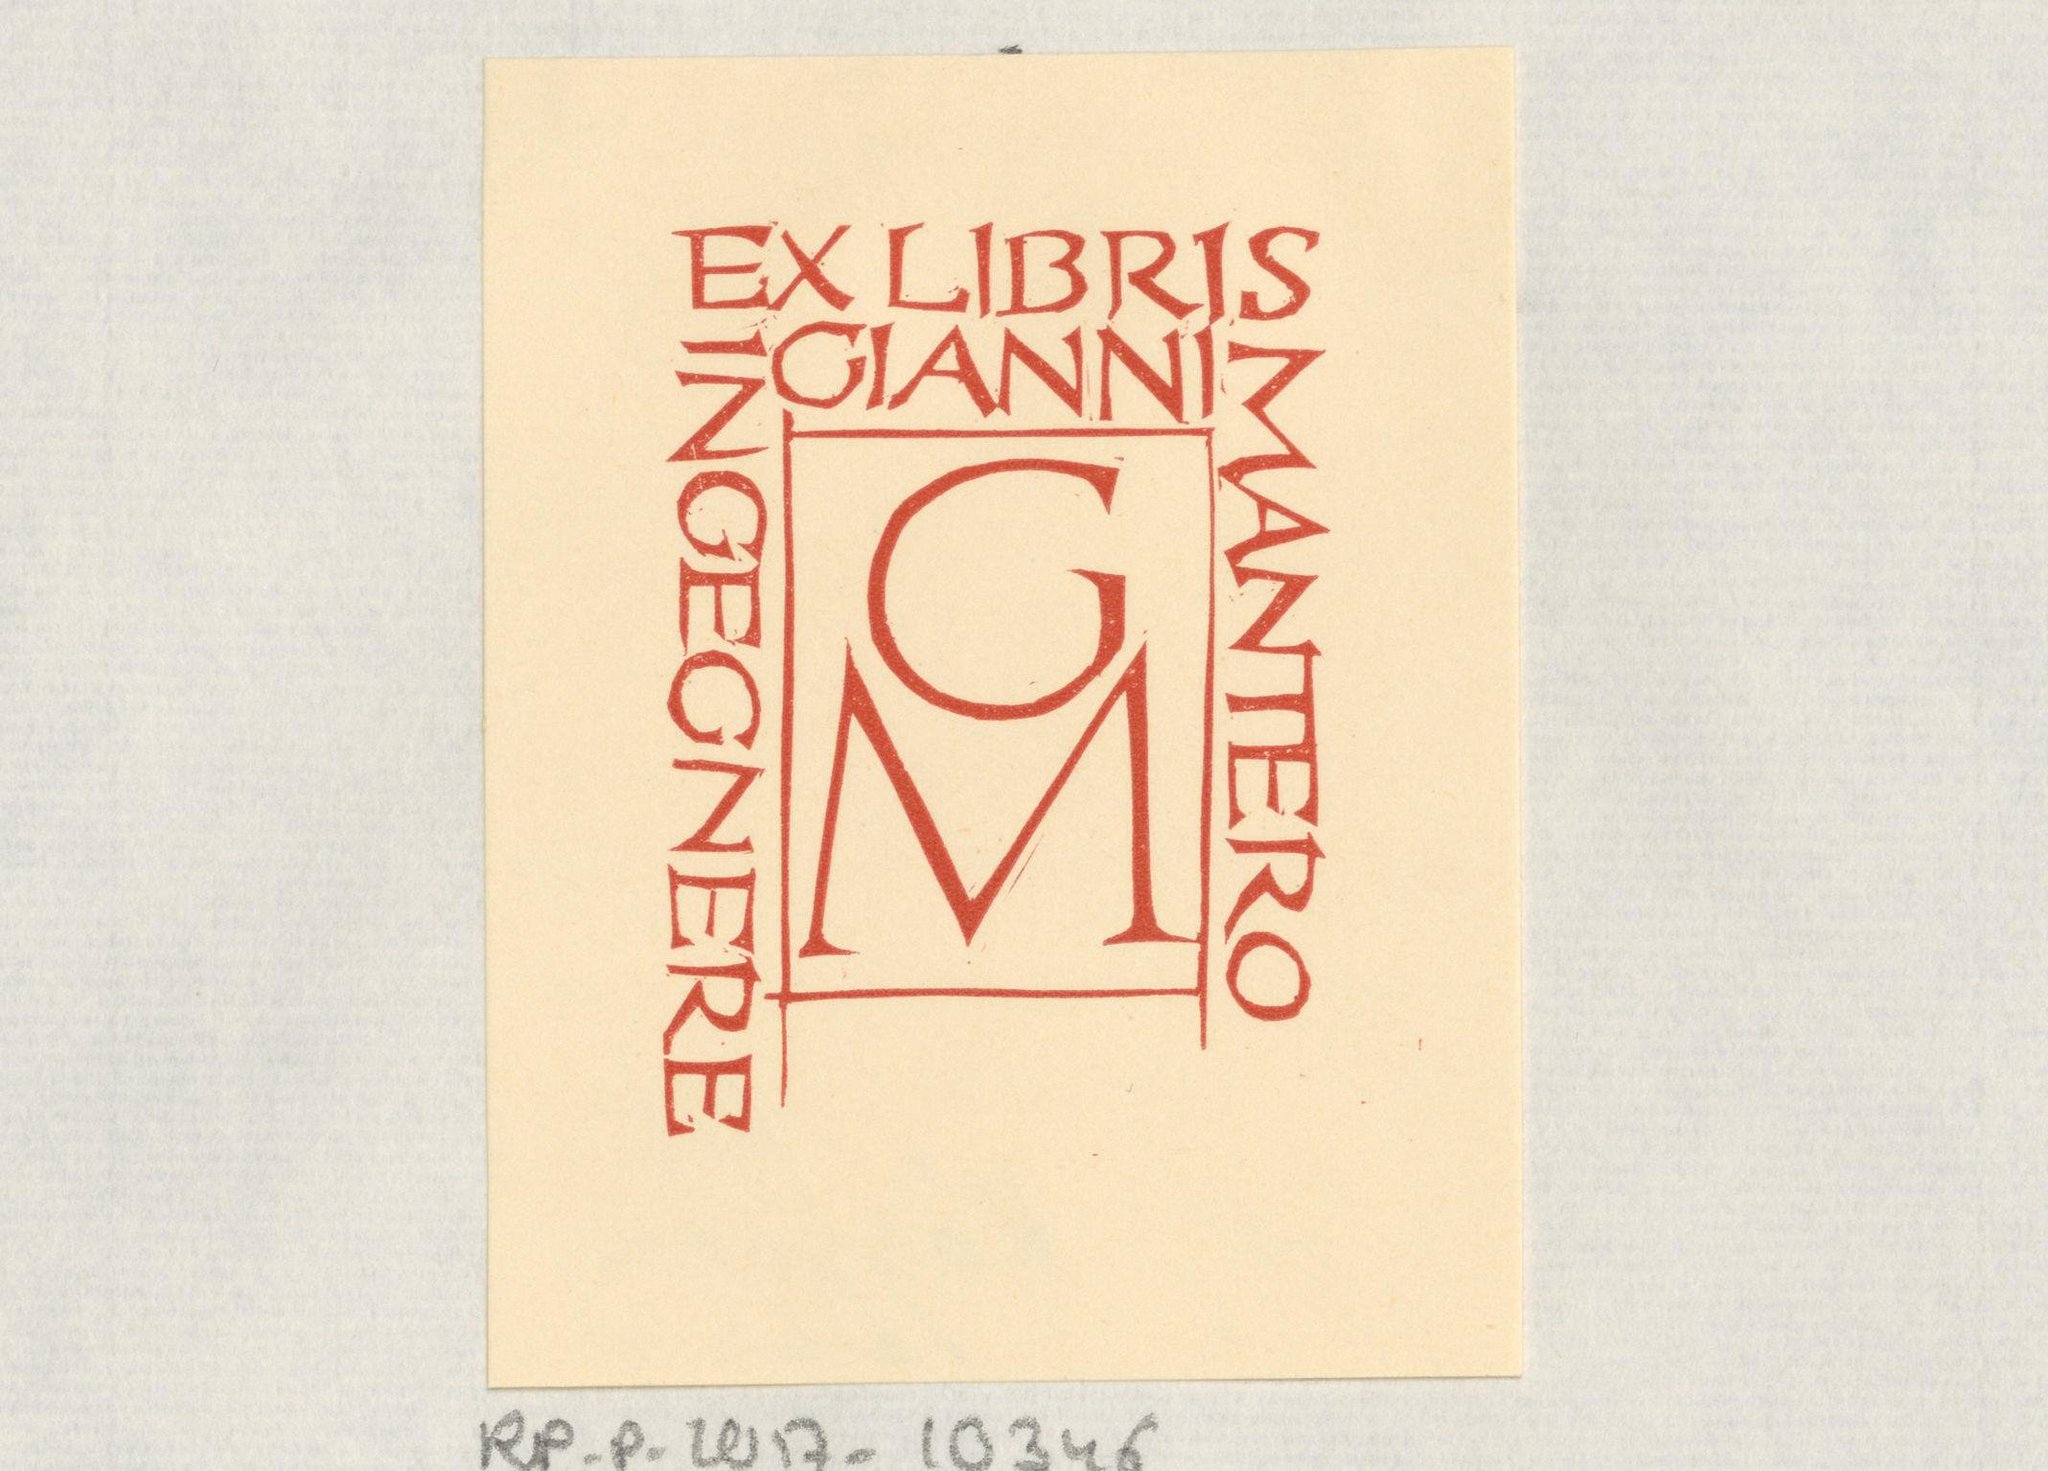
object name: bookplate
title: Ex libris van Gianni Mantero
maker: p. käßner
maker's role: print maker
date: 1907-1985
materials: paper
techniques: woodcut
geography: germany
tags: engineer, gianni mantero